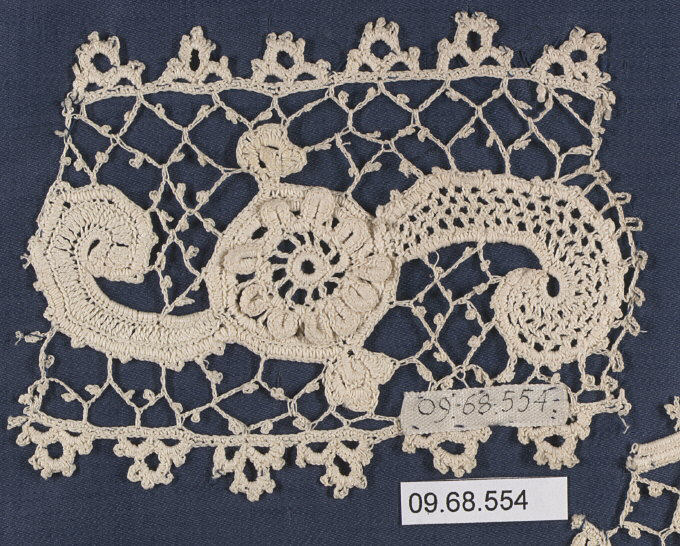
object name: specimen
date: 1801-1900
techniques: crochet